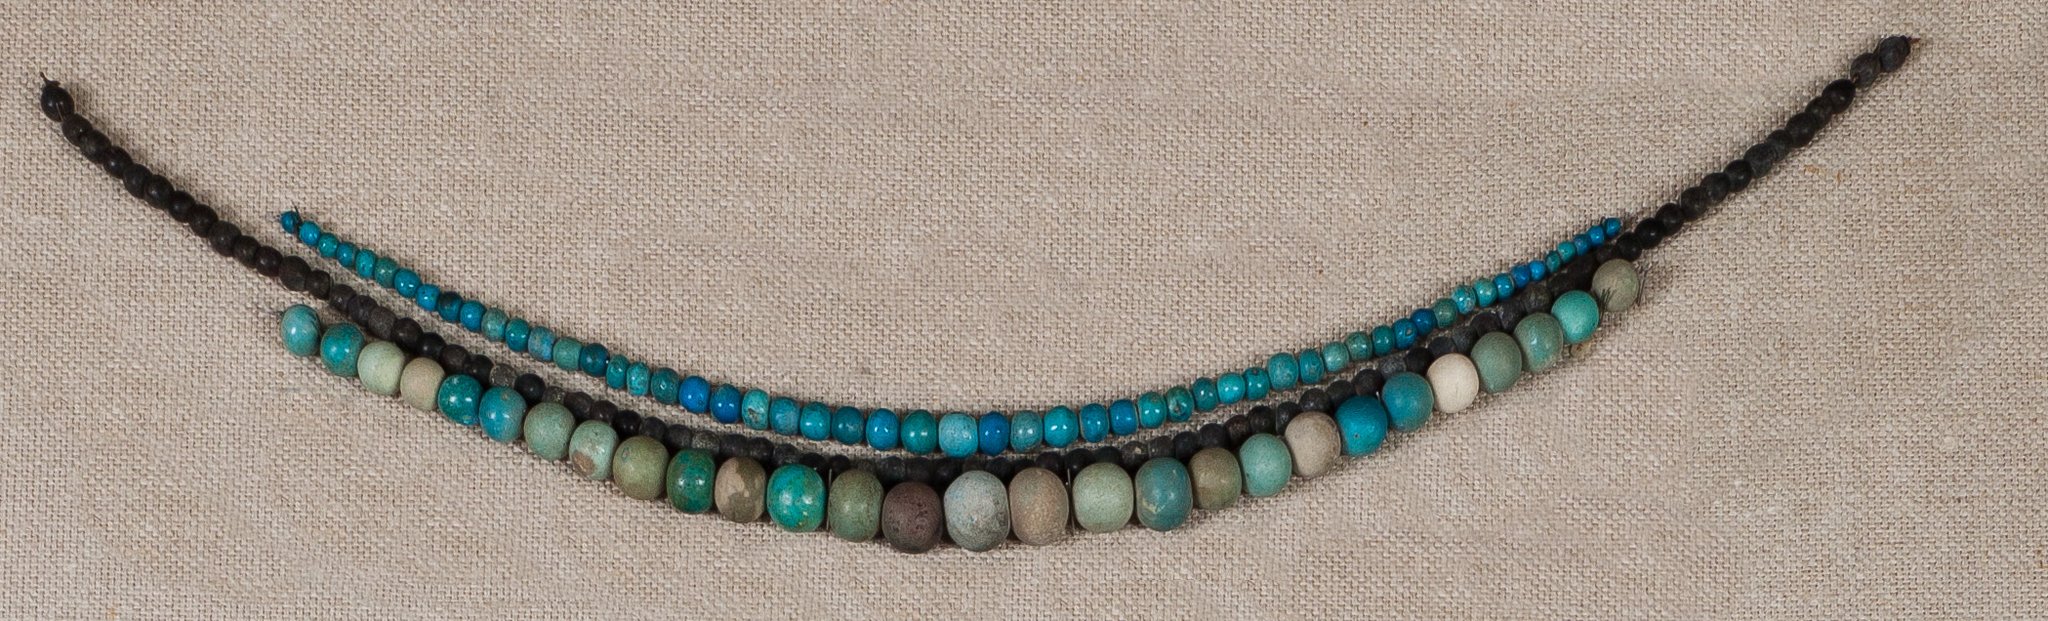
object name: necklace, bead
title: Necklace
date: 1981-1295 BCE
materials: faience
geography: egypt